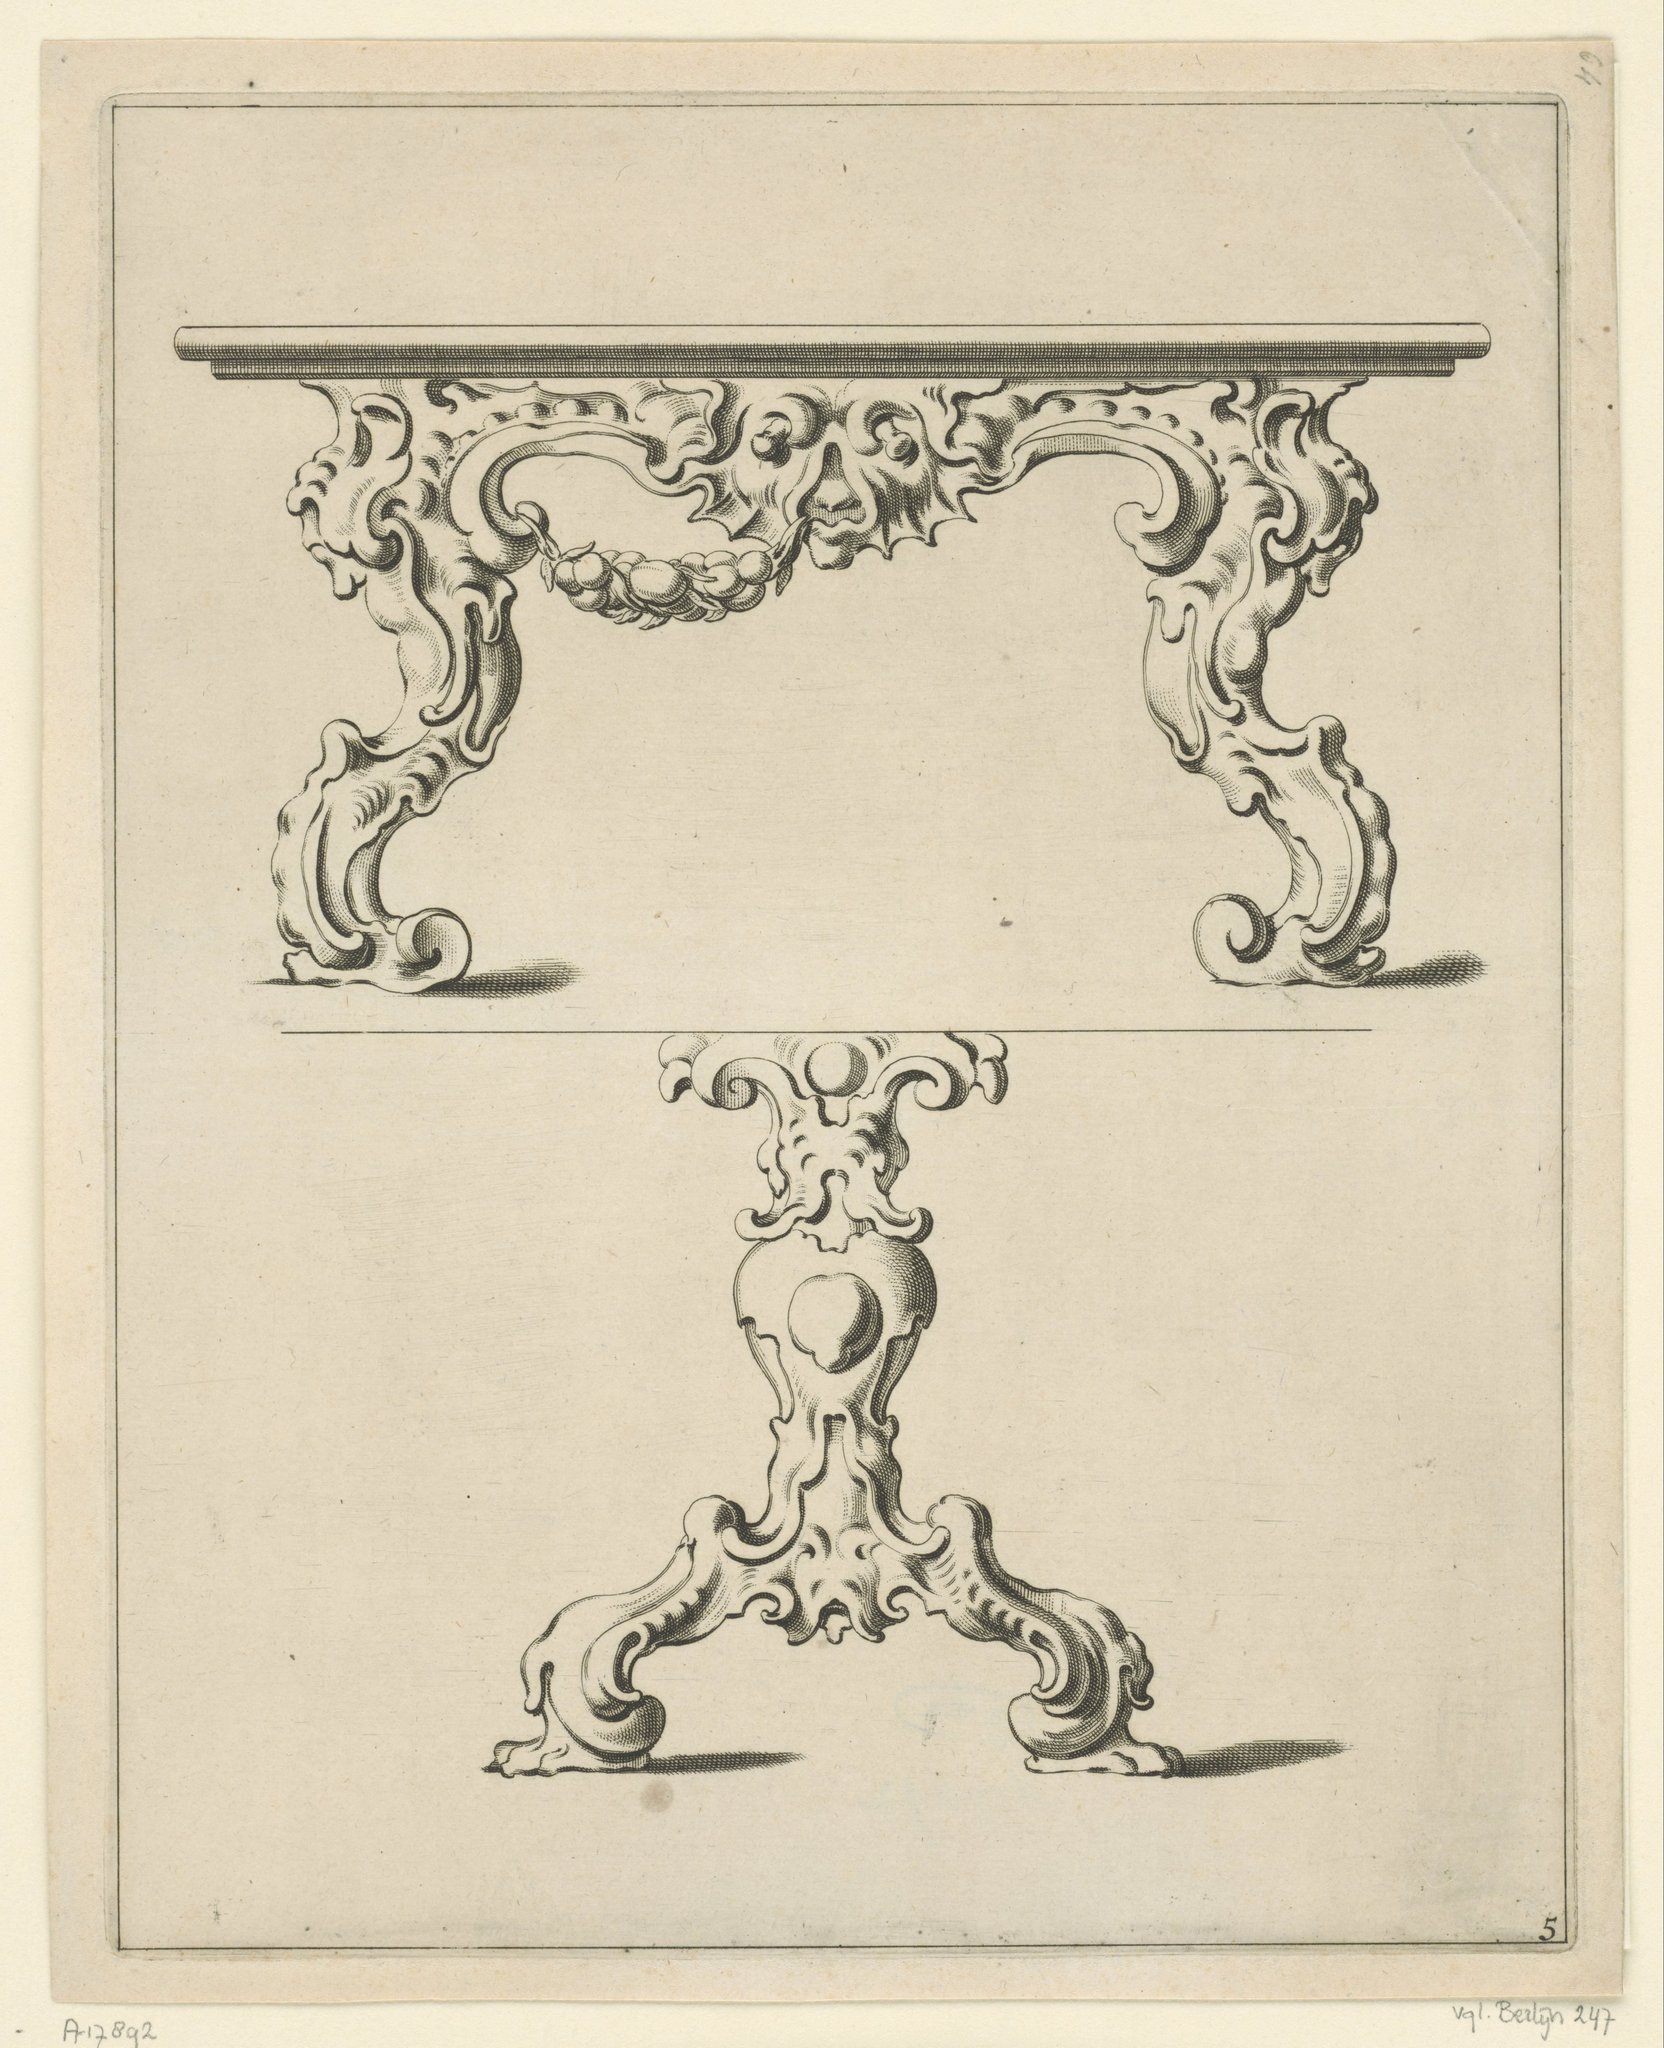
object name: print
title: Two Tables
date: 1655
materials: paper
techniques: etching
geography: netherlands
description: Stands for tables carved with auricular motifs were made in many Dutch cities. They usually combine kwab features with naturalistic elements, like the garland of fruit to the left of the table at the top. The lower one is a tripod (only two legs are visible). In 1655, when these prints were published, auricular tables had been in fashion for some time.